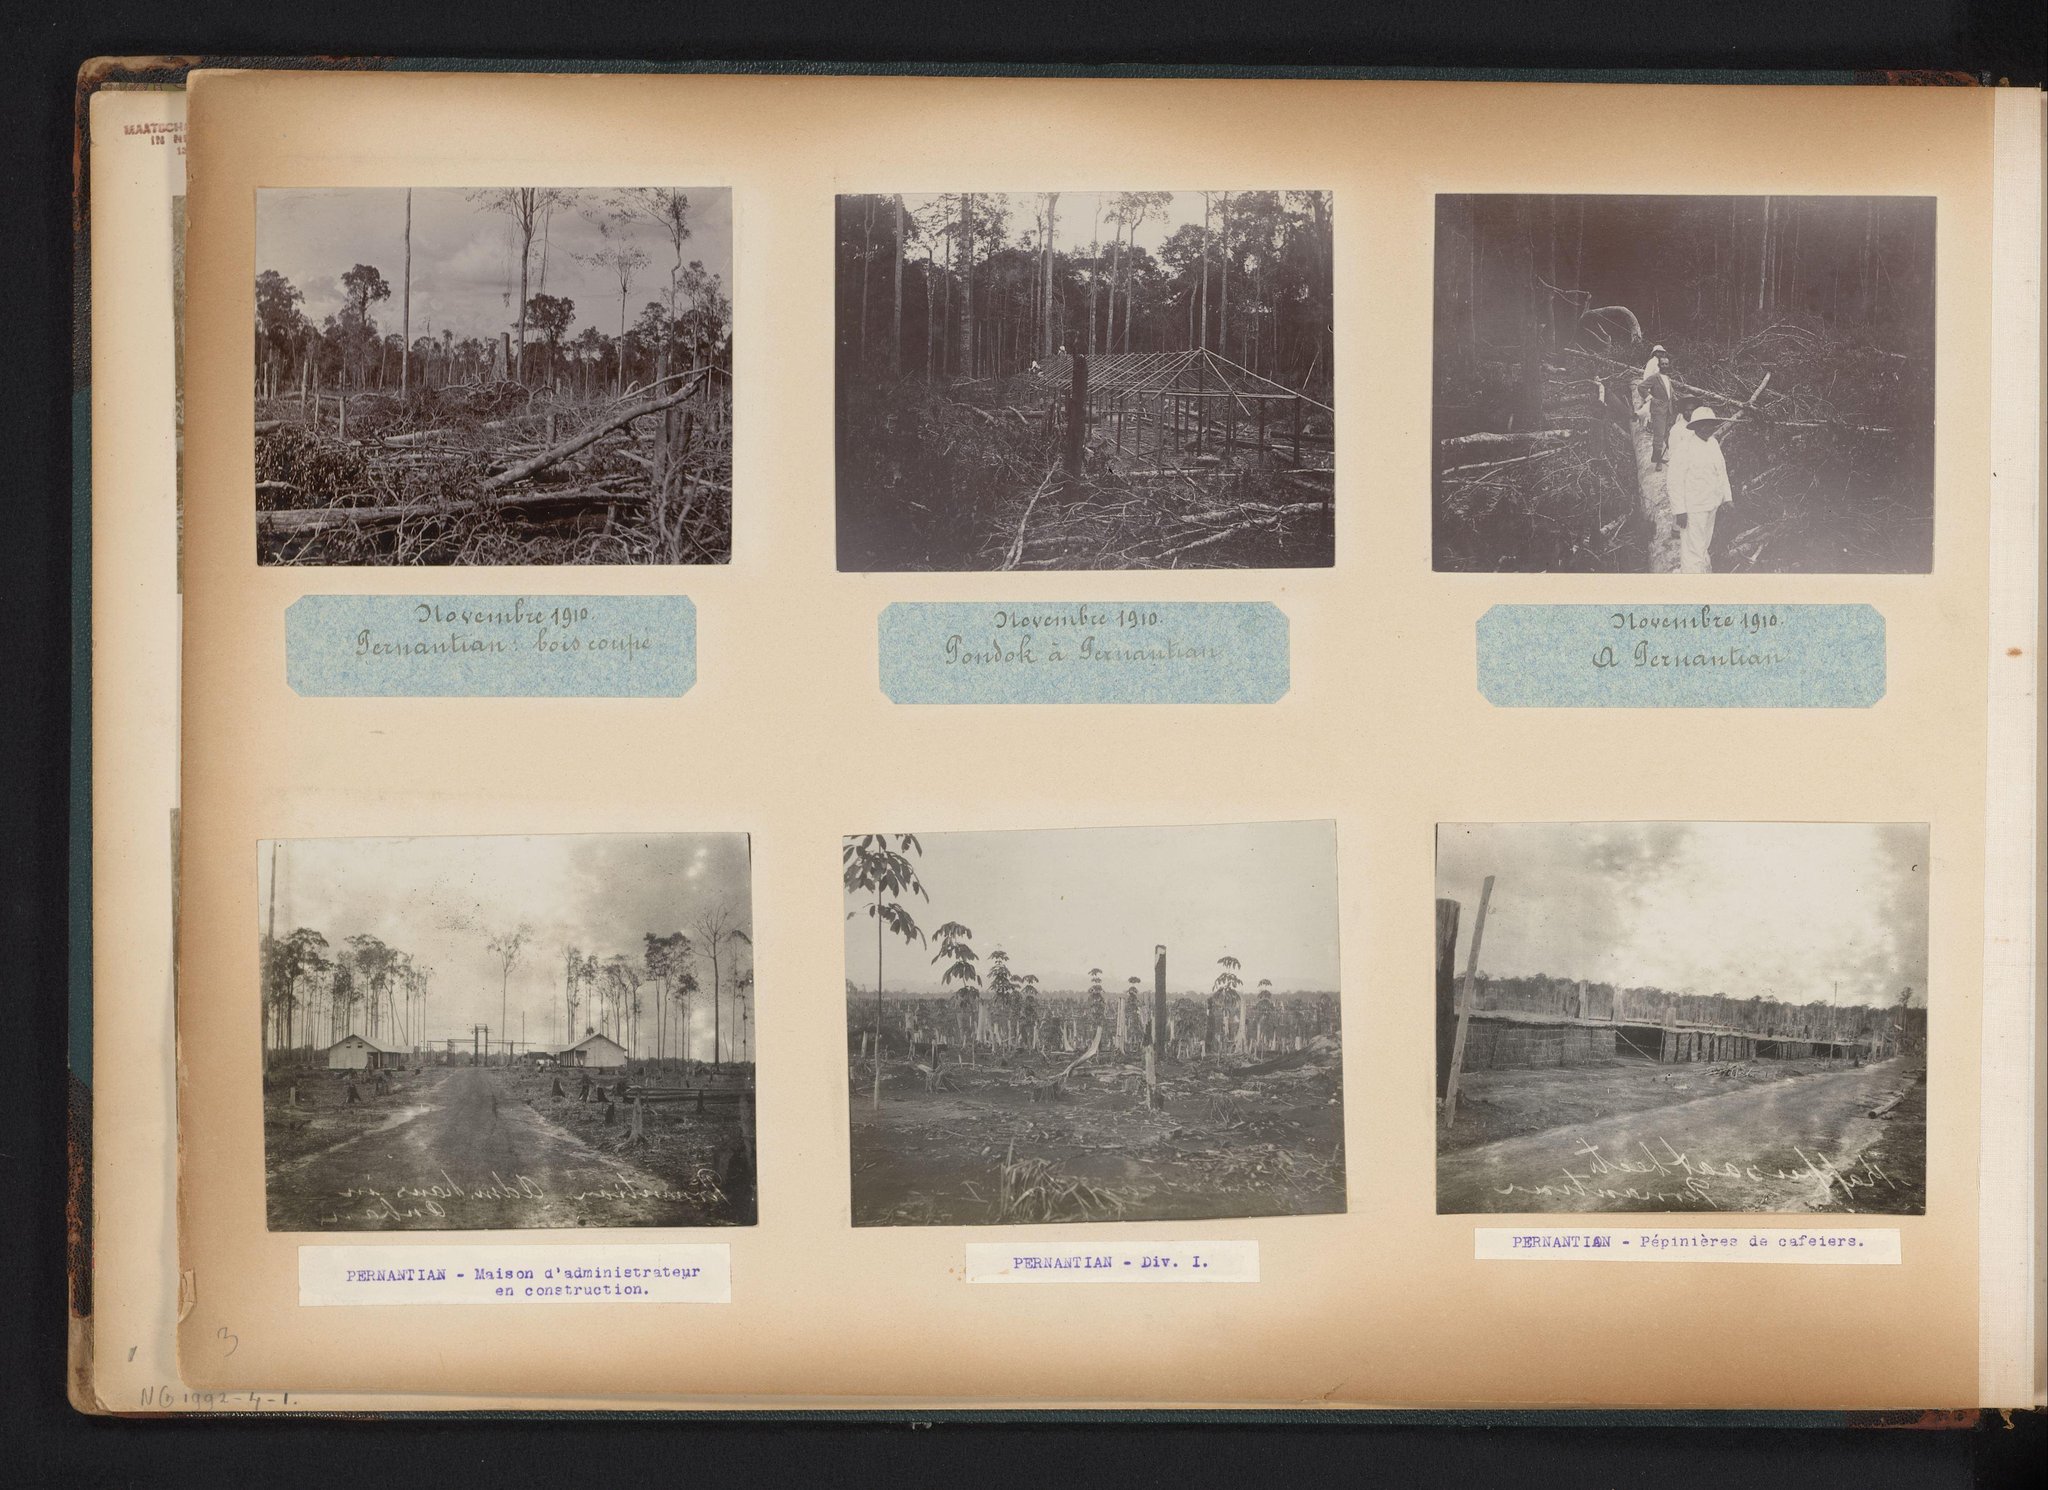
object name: photograph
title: Eerste aanplant en gebouwen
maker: Anonymous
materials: cardboard, photographic support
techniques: gelatin silver print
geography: east sumatra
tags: plantation, (non-fruit) products of plants or trees: rubber, fruits: coffee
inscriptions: inscription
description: Blad met zes foto's van eerste aanplant van rubberbomen, constructie van verschillende gebouwen en een kwekerij voor koffieplanten. November 1910 en later. Onder de foto's etiketten met onderschriften. Onderdeel van het fotoalbum over de plantages Brussel en Pernantian van de Sumatra Caoutchouc Maatschappij op de Oostkust van Sumatra in de jaren 1910-1935.